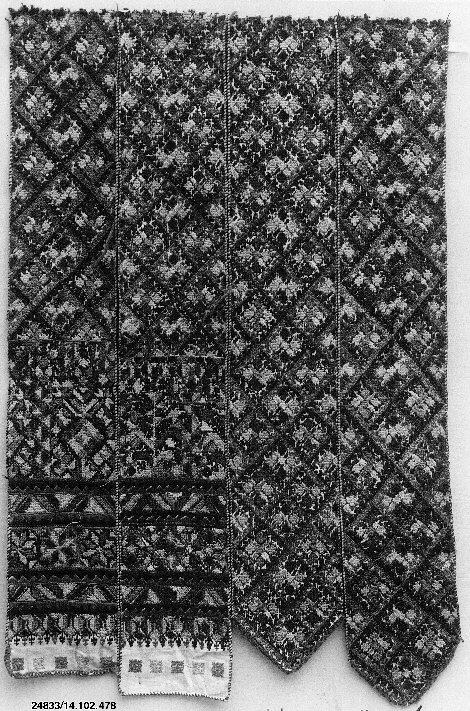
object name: belt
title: Belts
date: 1801-1900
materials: linen, silk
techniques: embroidery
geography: morocco